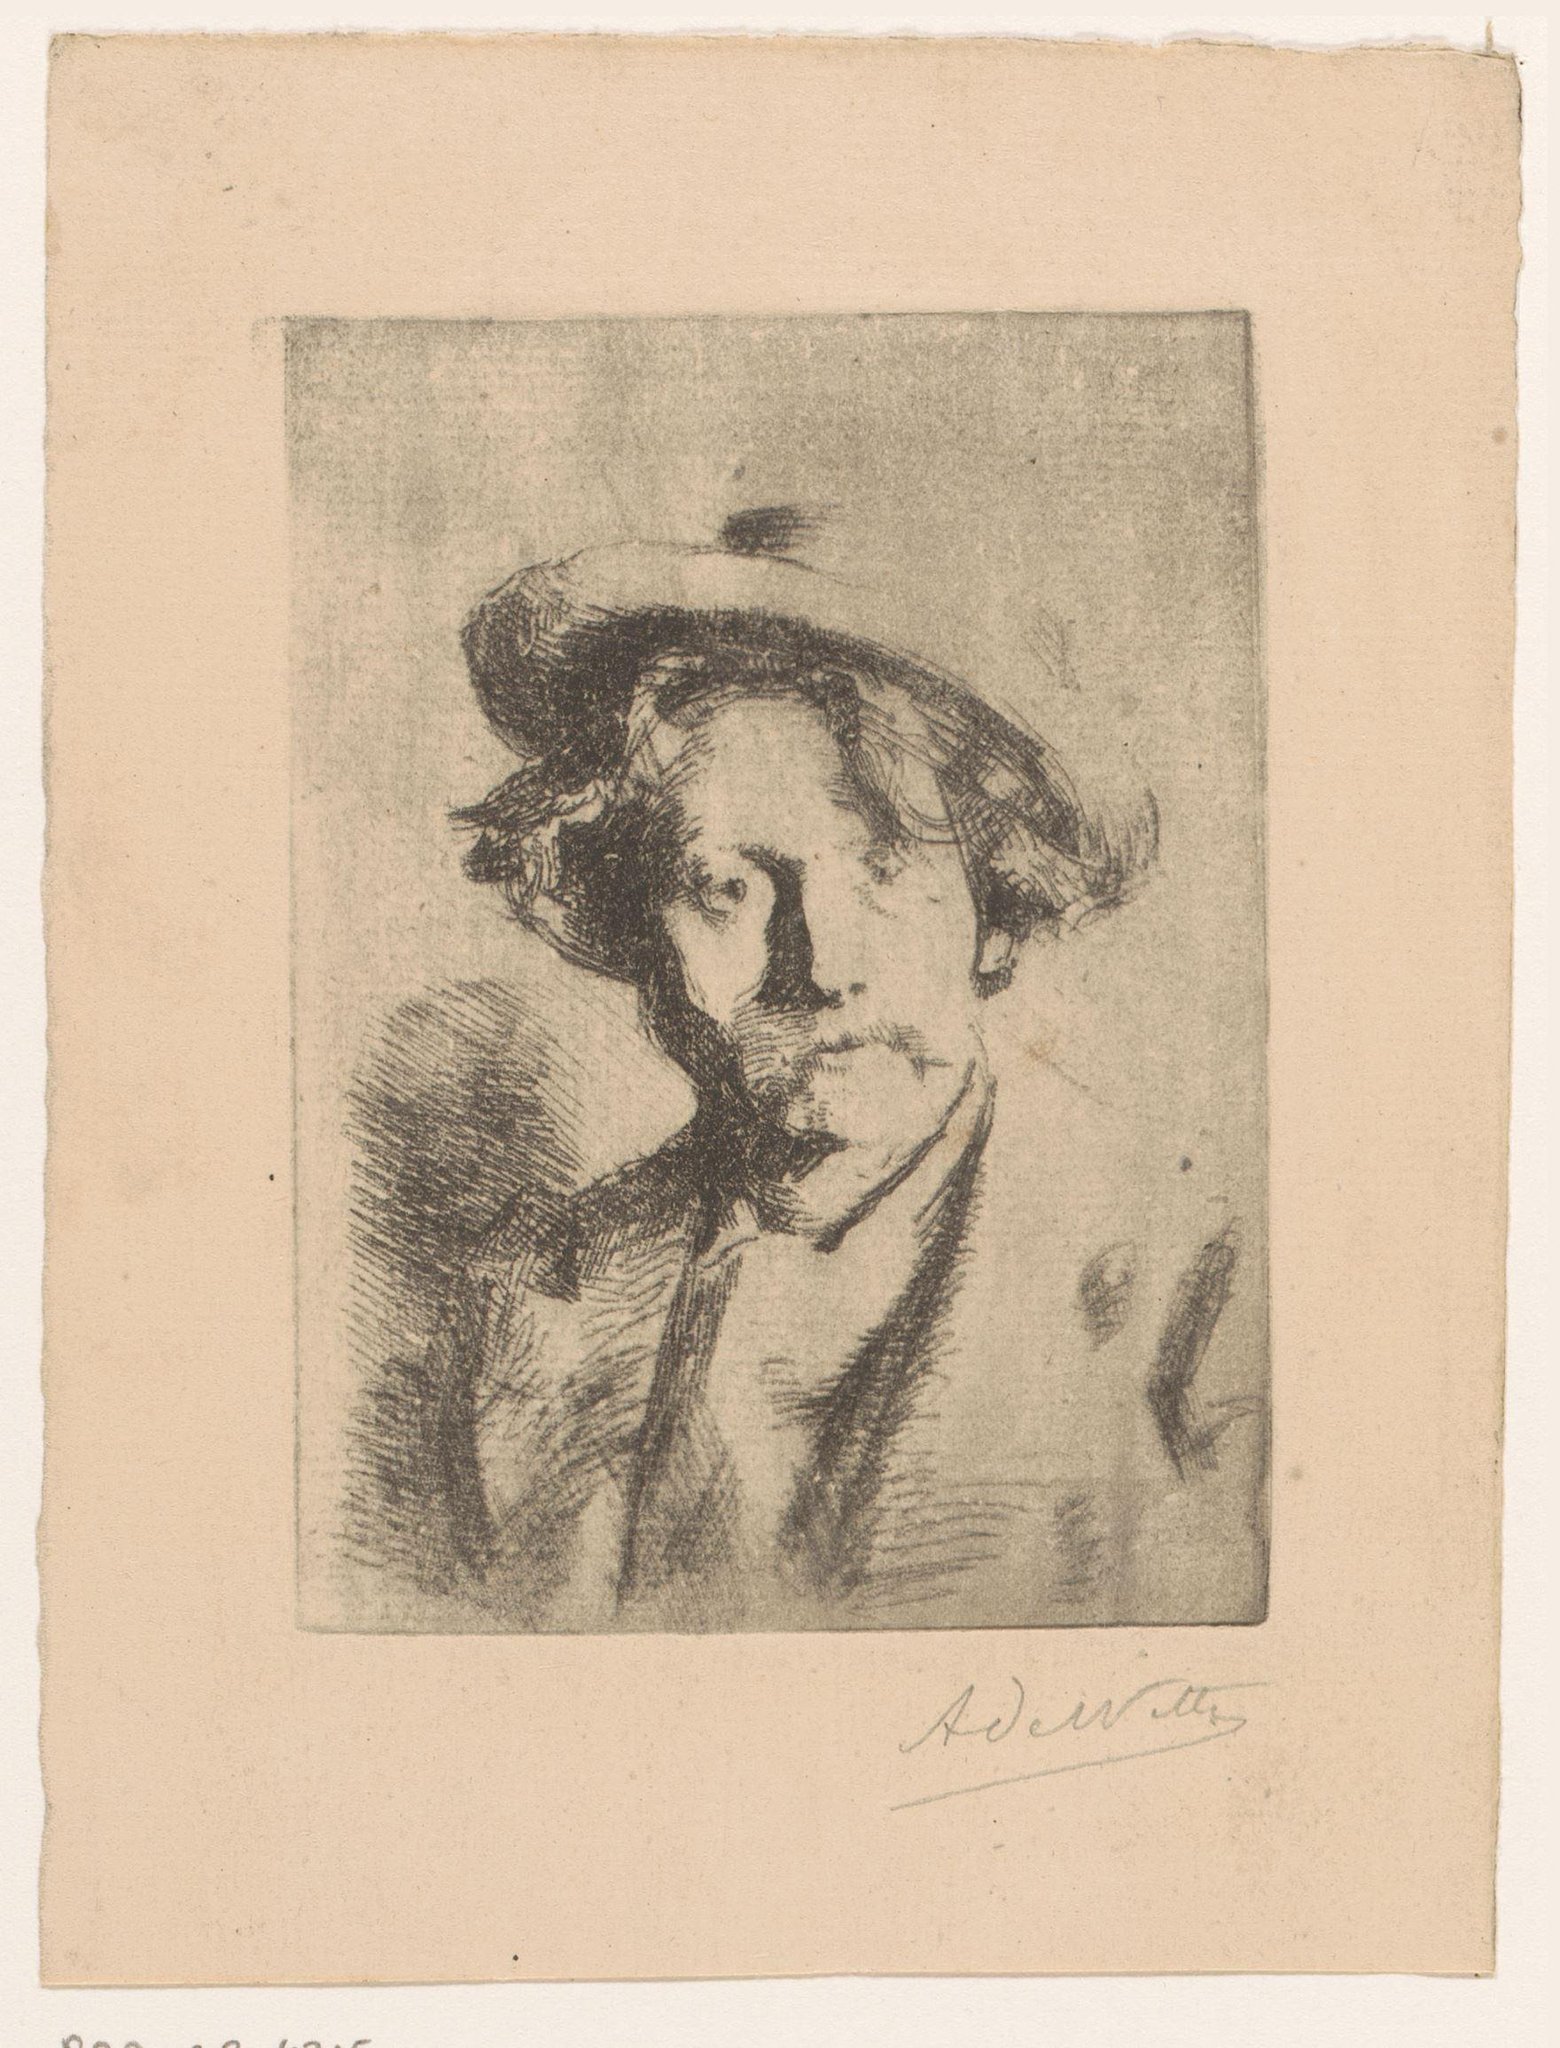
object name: print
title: Portret van Léon-Hubert Zeyen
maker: adrien de witte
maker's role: print maker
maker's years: 1850-1935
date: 1876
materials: paper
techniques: etching, intaglio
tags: léonard hubert zeyen, adult man, historical persons, head-gear: hat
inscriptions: collector's mark: Lugt 2228